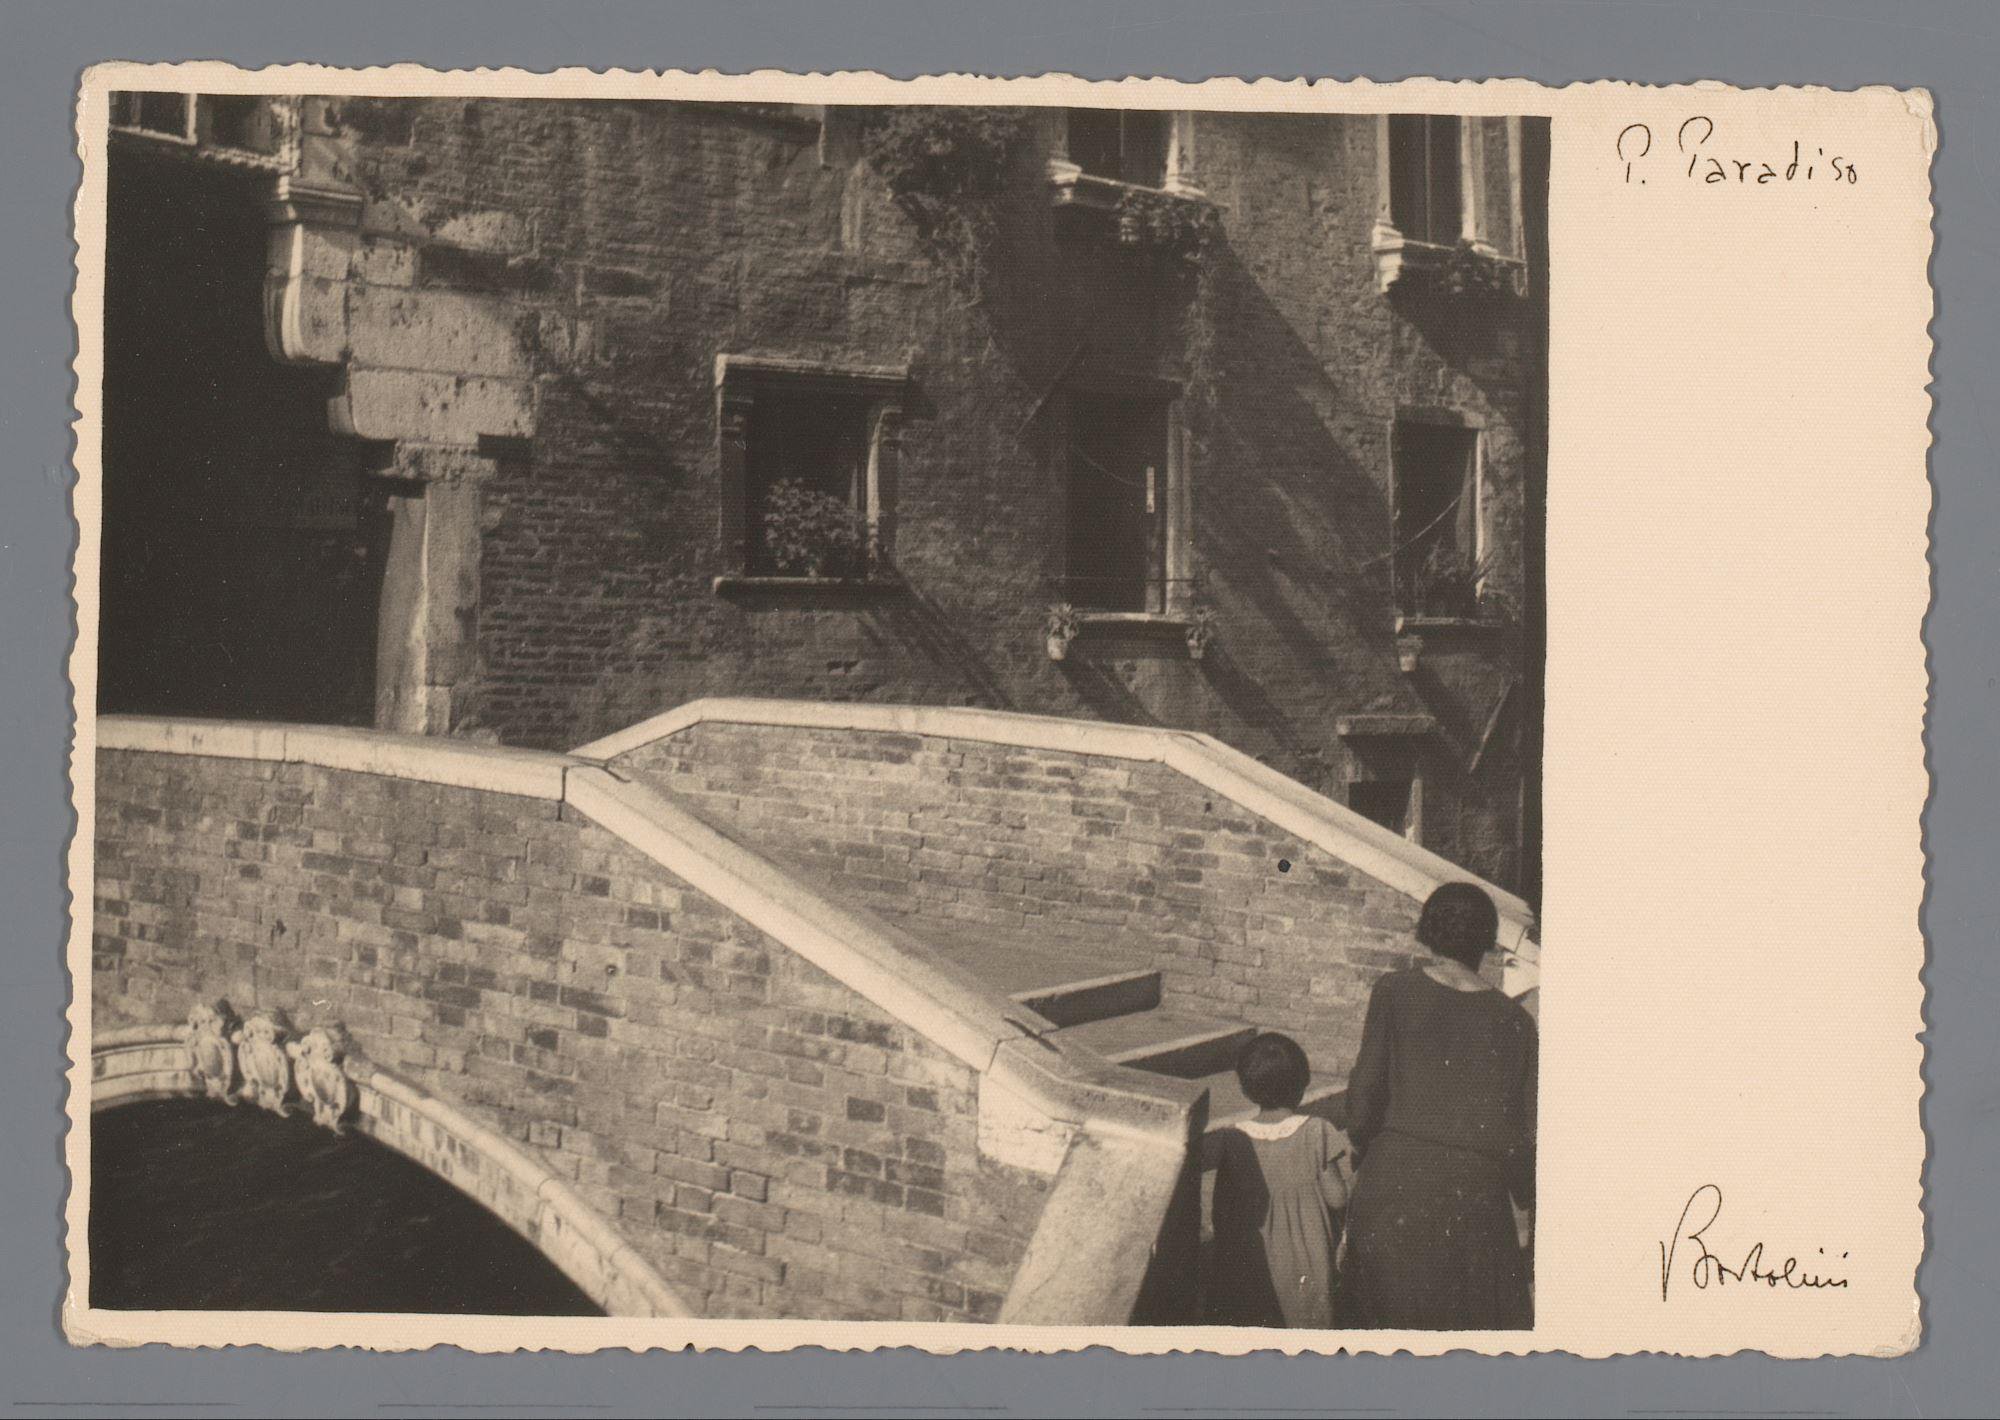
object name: ansichtkaart, prentbriefkaart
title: Ponte del Paradiso in Venetië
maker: bartolini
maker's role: fotograaf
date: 1907-1940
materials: paper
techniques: gelatin silver print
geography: venice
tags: bridge in city across river, canal, etc., venice